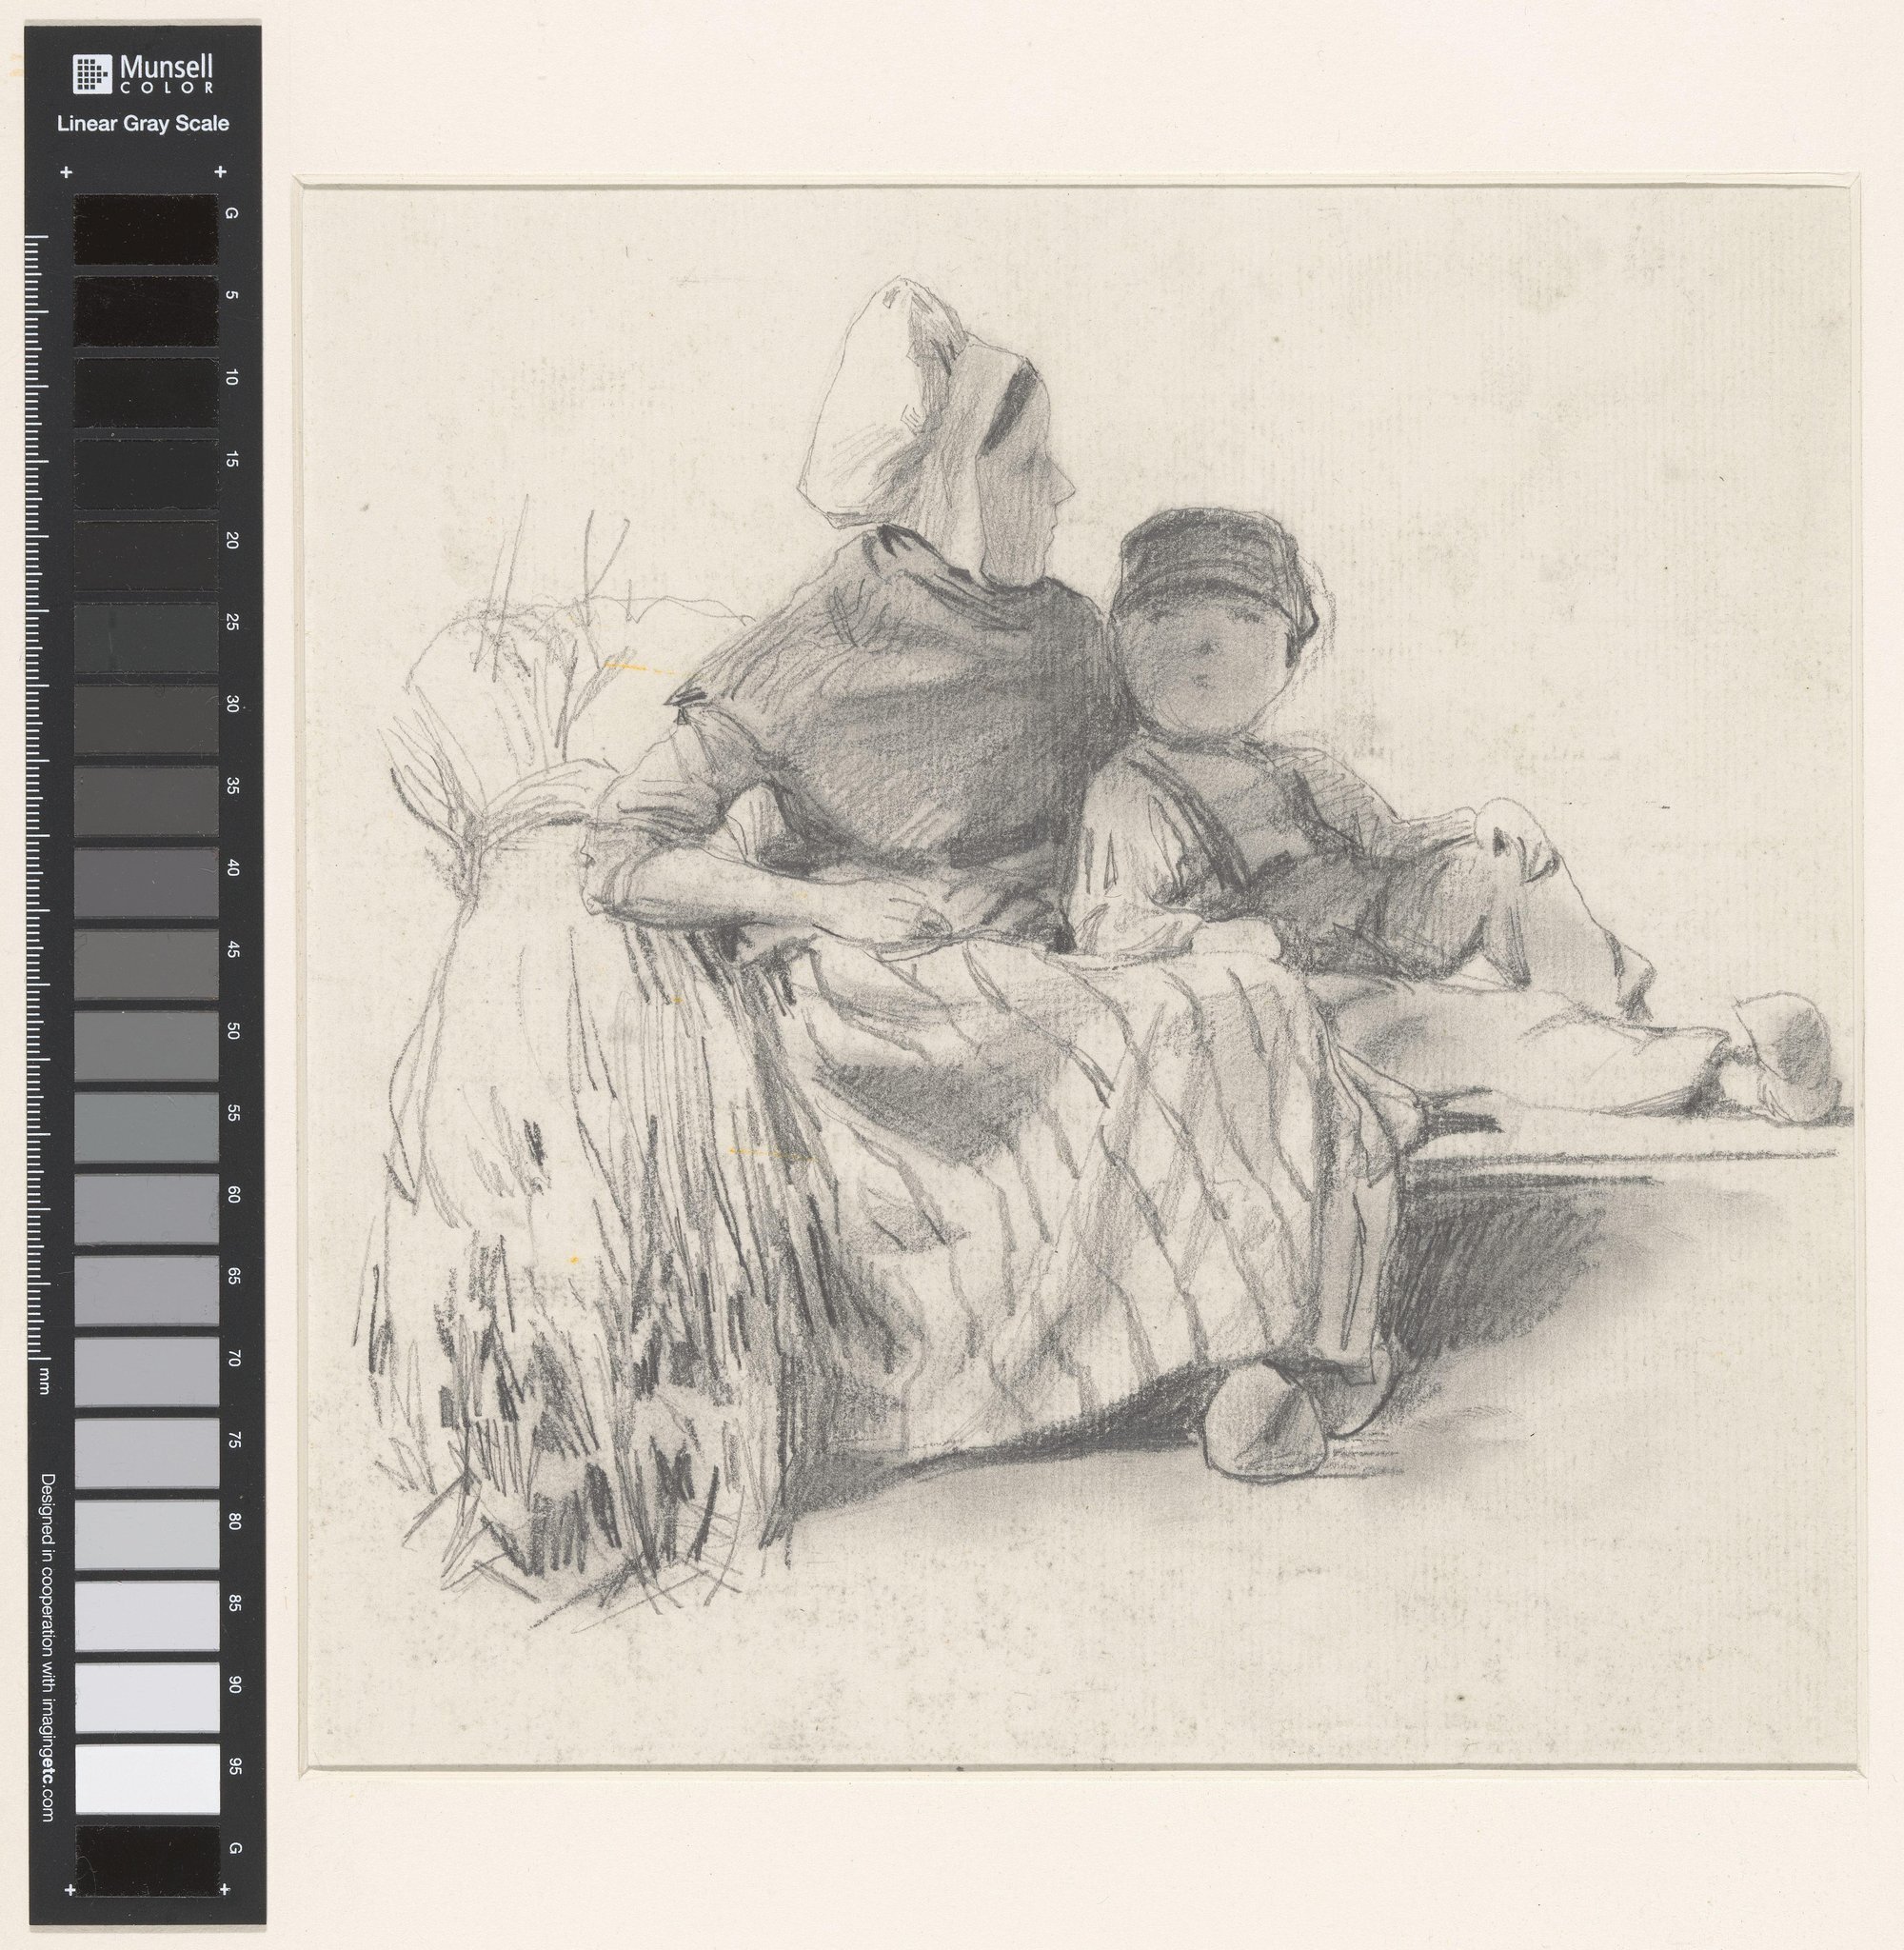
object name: drawing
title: Zittend boerenmeisje met naast zich een jongetje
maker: jan weissenbruch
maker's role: painter, print maker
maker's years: 1822-1880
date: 1832-1880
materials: paper, pencil